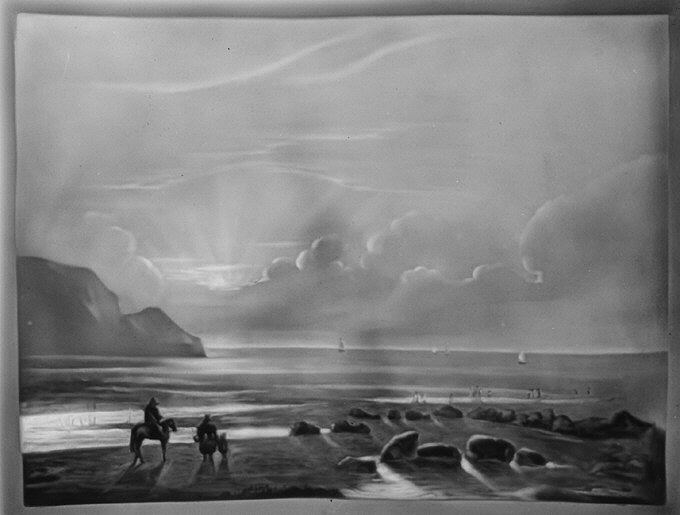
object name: lithophane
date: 1834-1866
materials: porcelain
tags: human figures,horses,seascapes